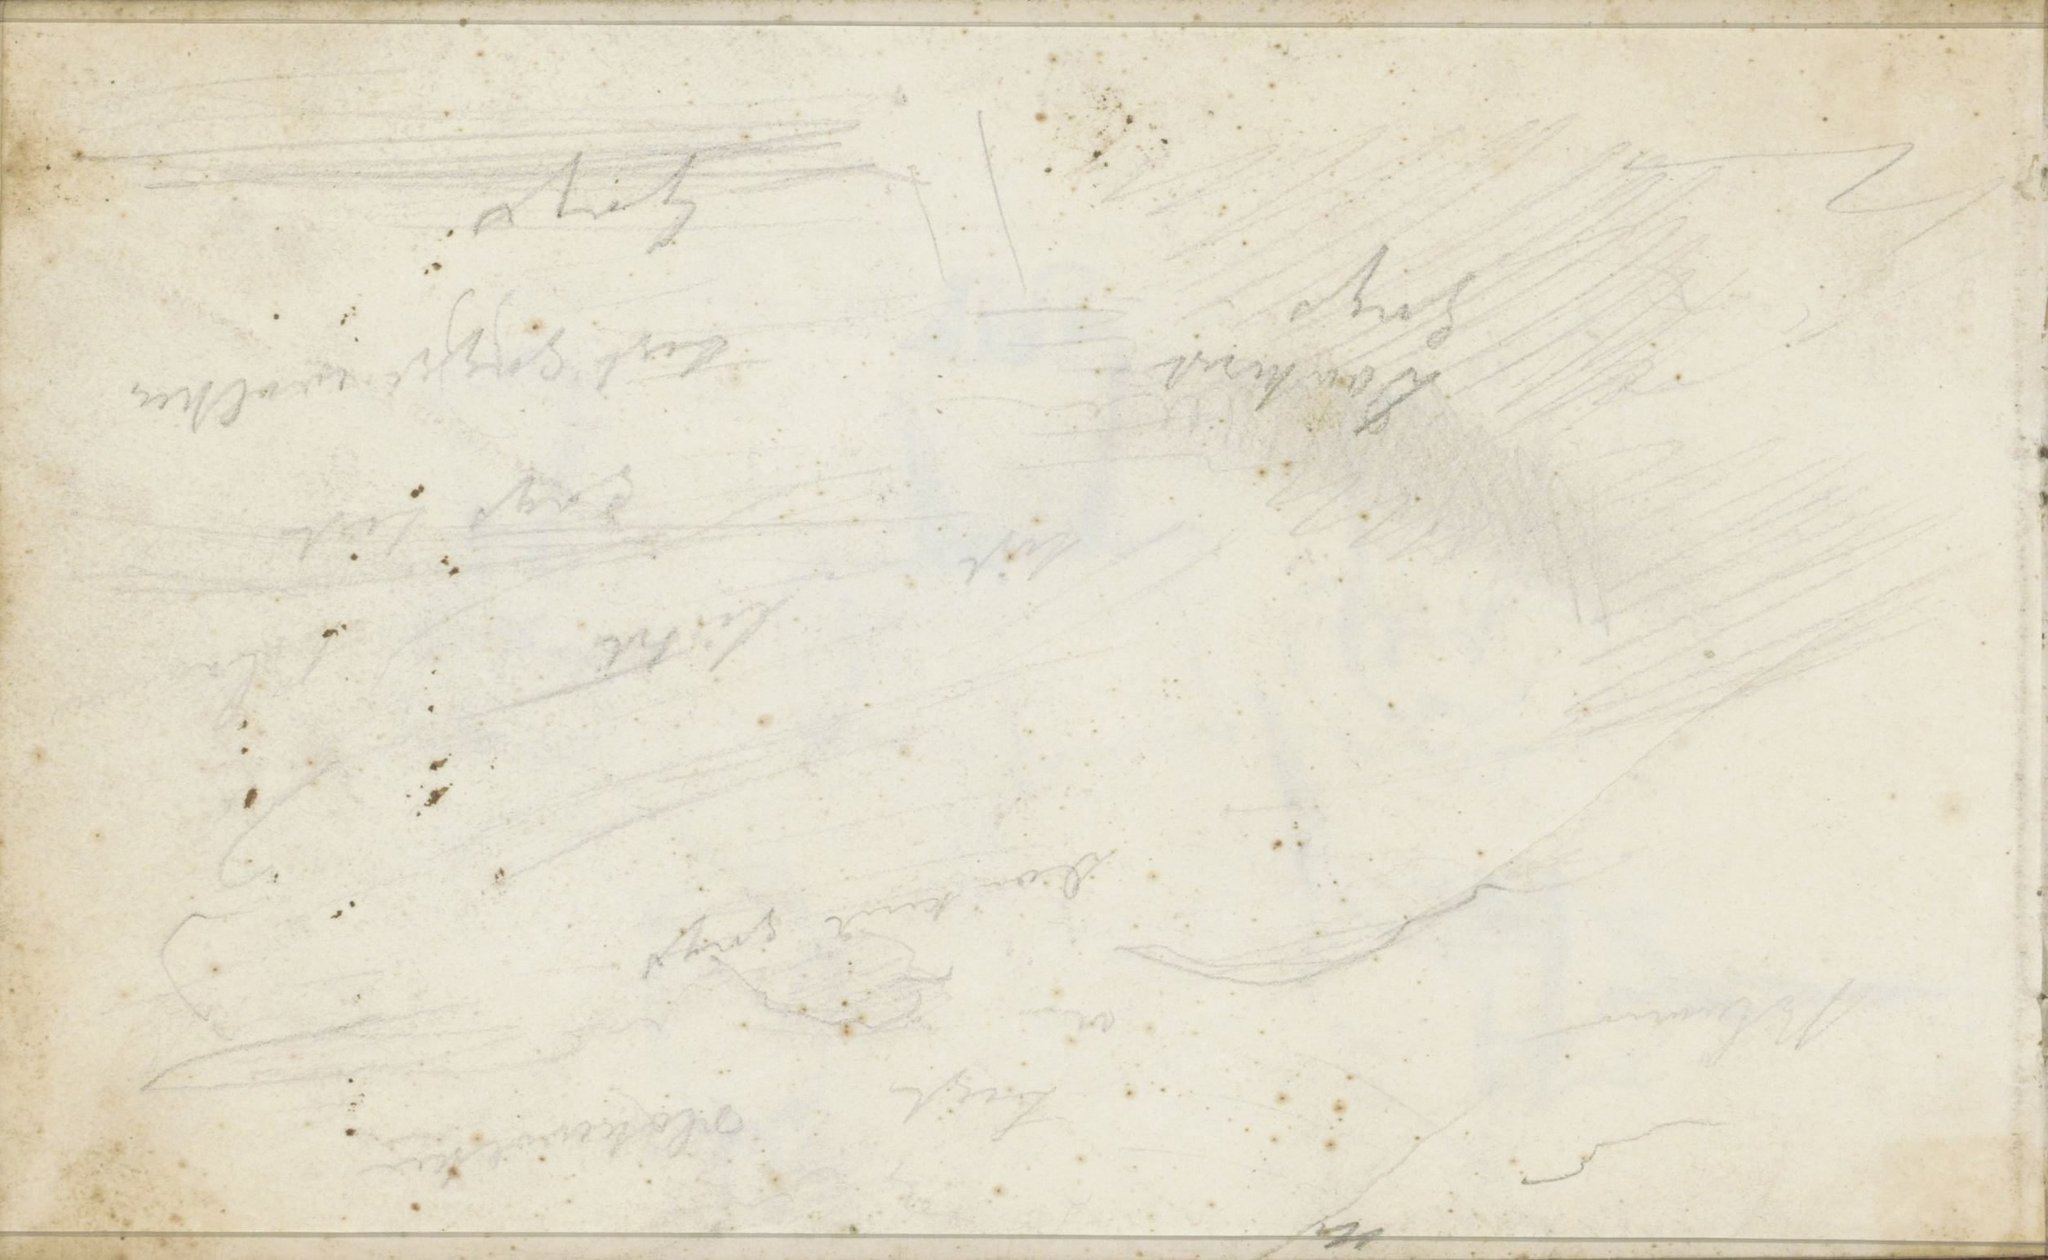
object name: sketchbook leaf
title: Bergen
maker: johannes tavenraat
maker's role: draughtsman, painter, print maker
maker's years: 1809-1881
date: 1840-1841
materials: paper, pencil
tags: mountains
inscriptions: kleurnotitie, handgeschreven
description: Blad 41 verso uit een schetsboek met 41 bladen.